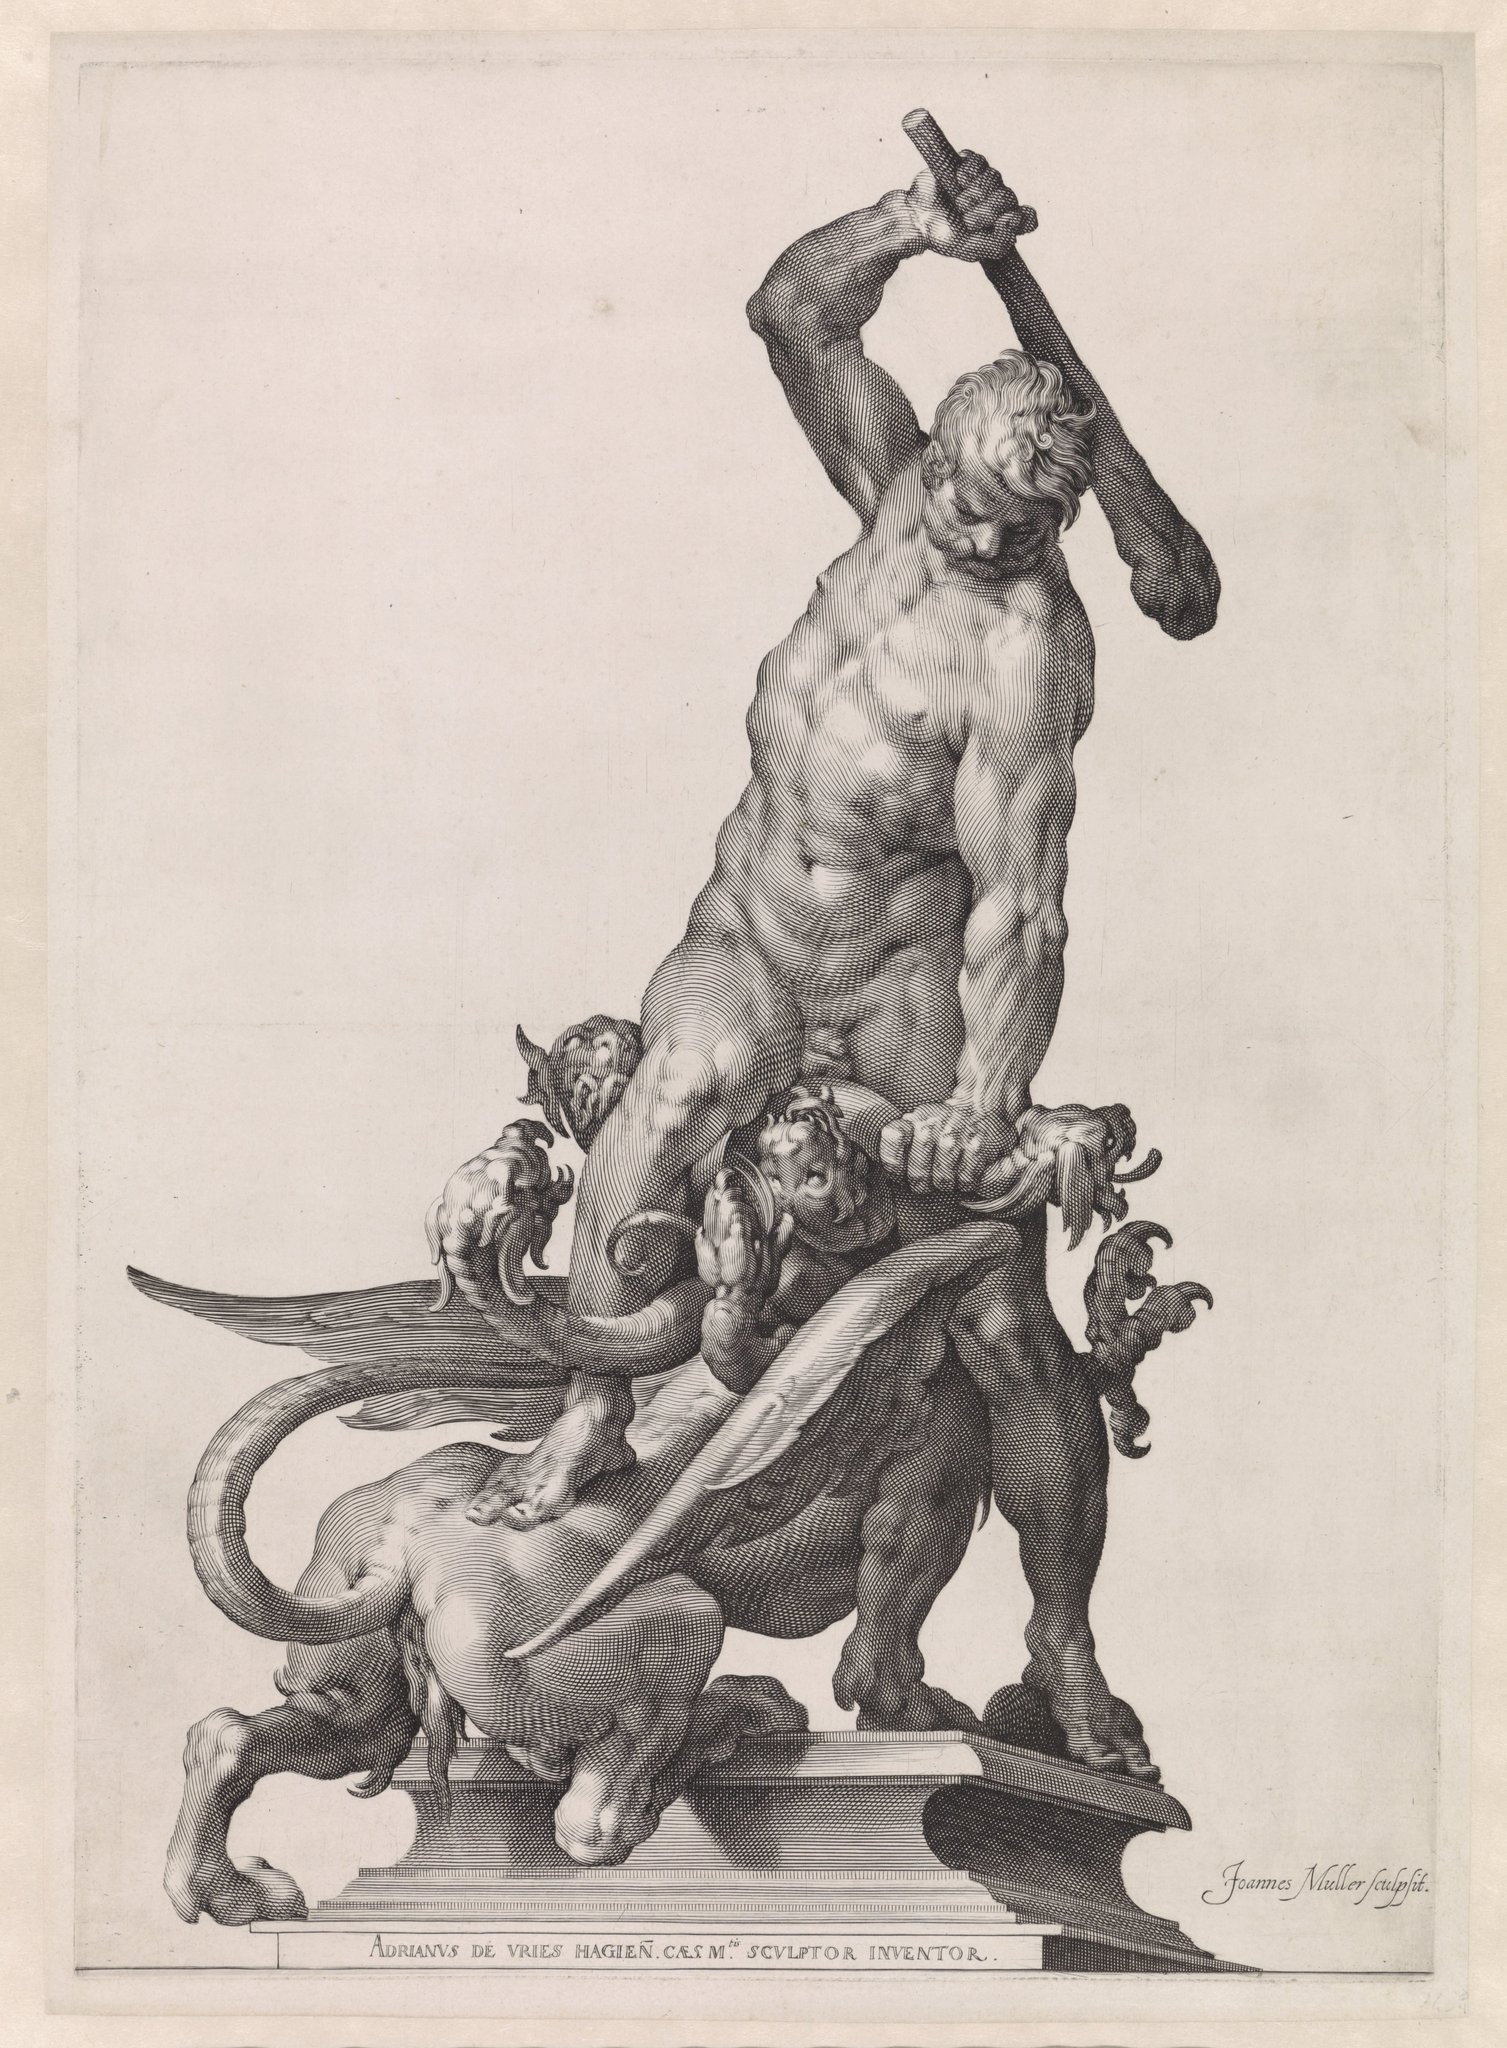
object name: print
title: Hercules doodt de hydra van Lerna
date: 1600-1604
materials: paper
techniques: engraving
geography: amsterdam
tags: (2) the hydra of lerna is killed by hercules, piece of sculpture, reproduction of a piece of sculpture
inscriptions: collector's mark: Lugt 240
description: Hercules doodt met een knuppel de hydra van Lerna. Naar een fonteinsculptuur van beeldhouwer Adriaen de Vries.